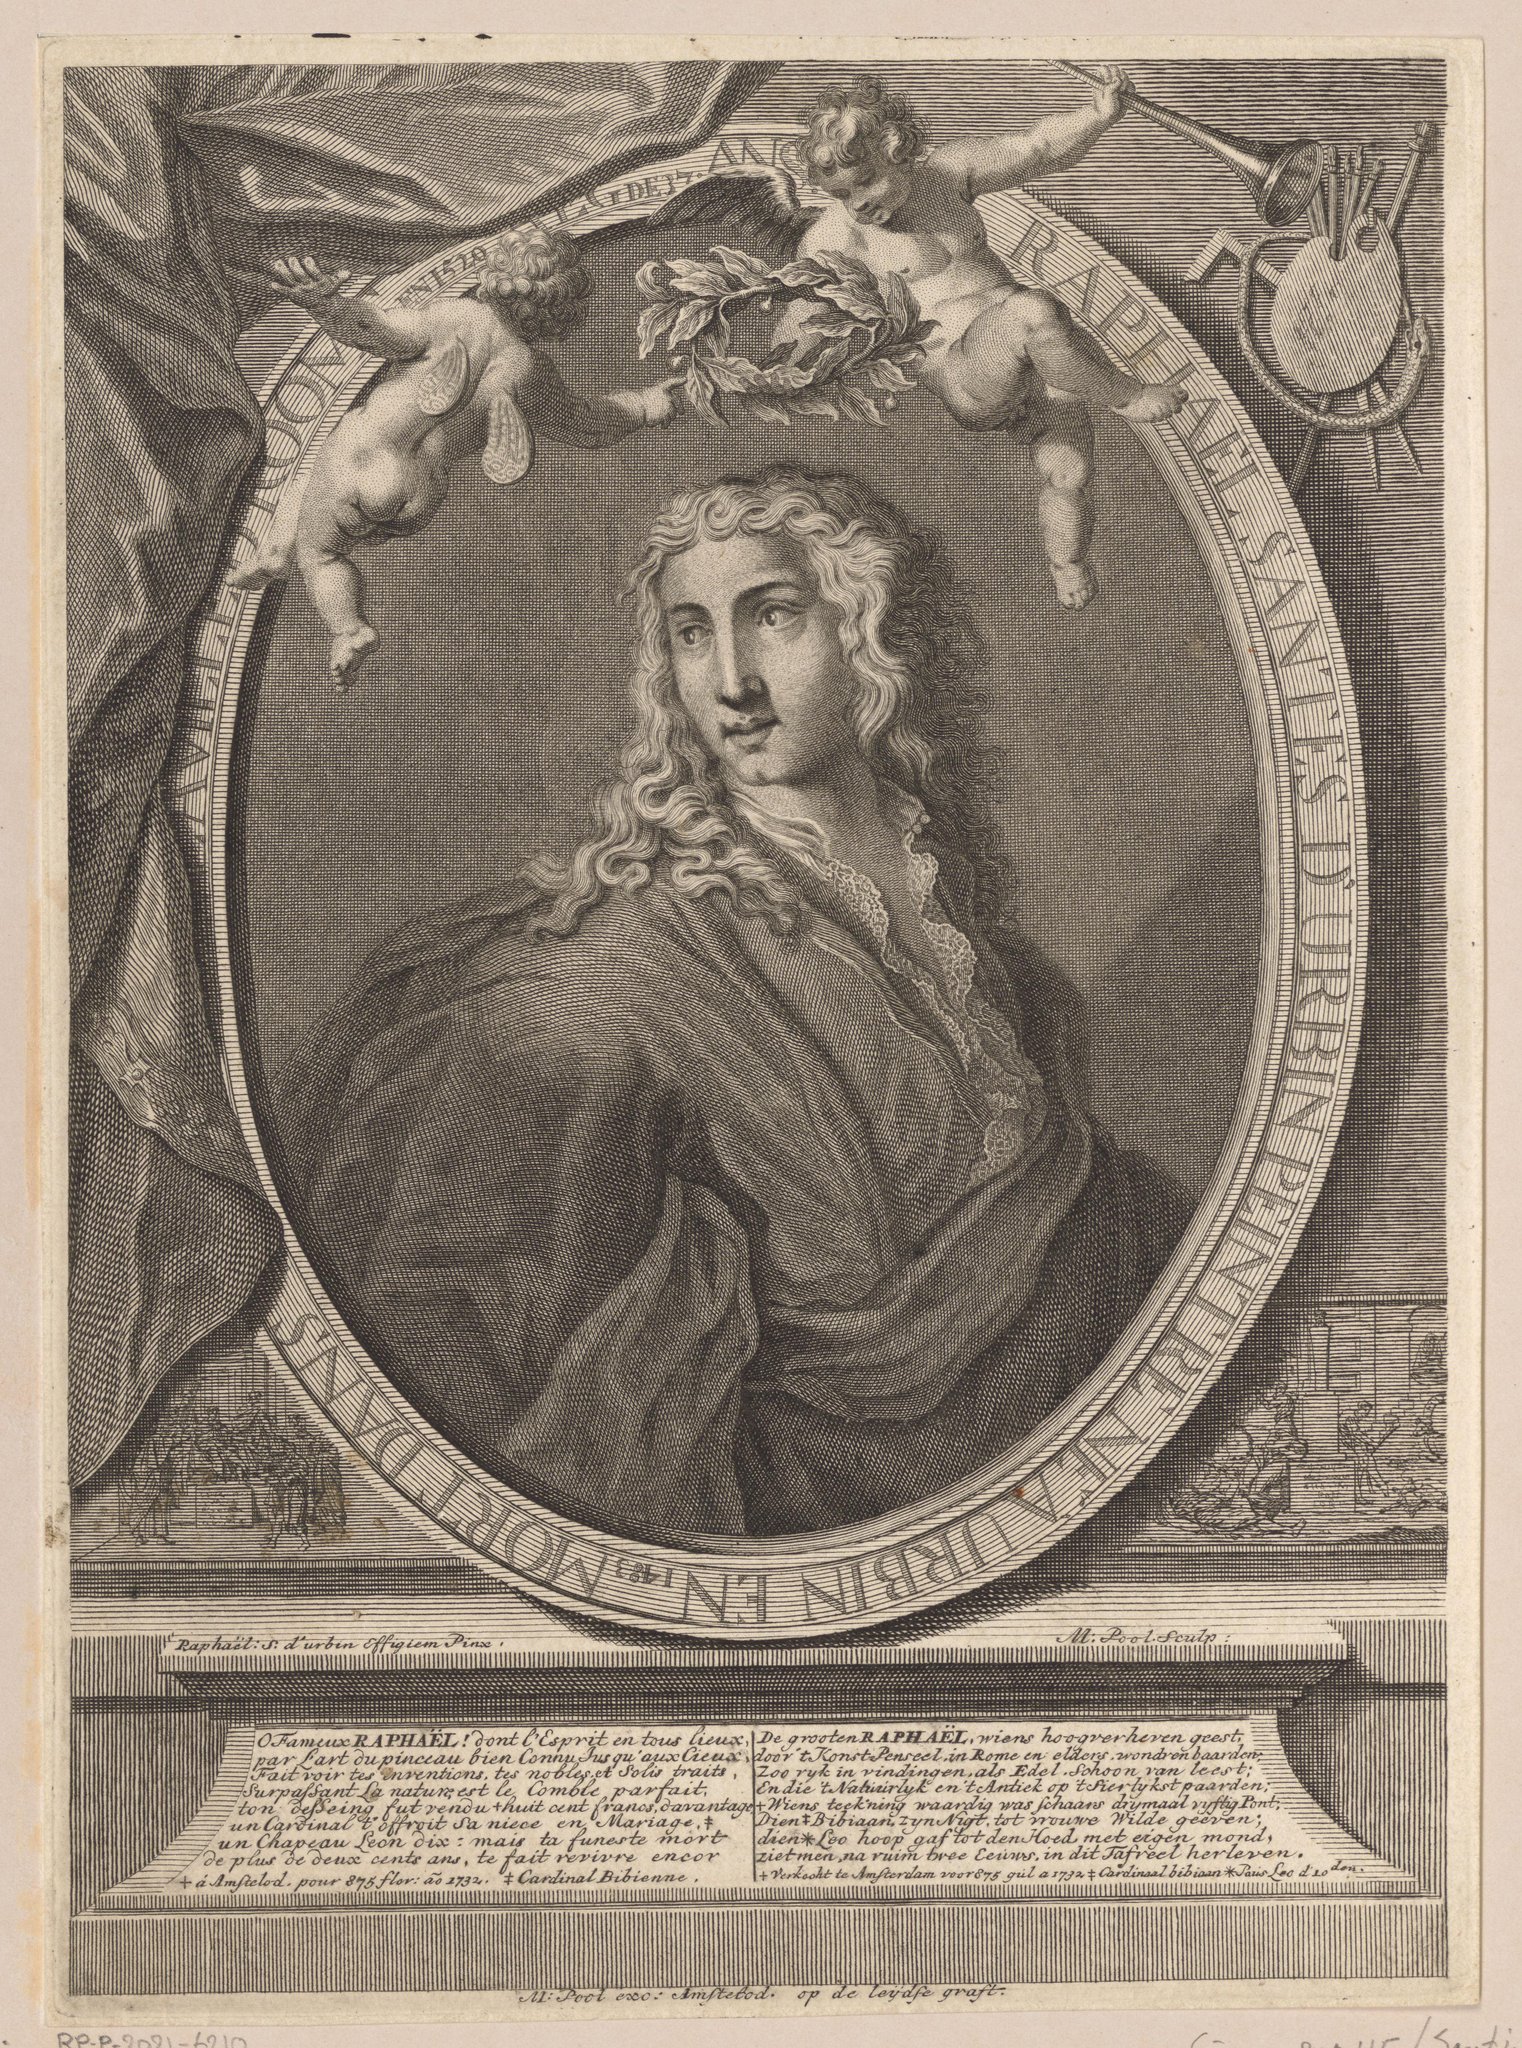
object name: print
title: Portret van Rafaël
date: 1732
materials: paper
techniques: engraving, etching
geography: amsterdam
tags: rome, painter, rafaël, historical persons, crowning with laurel, cupids: 'amores', 'amoretti', 'putti'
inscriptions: date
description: Rafaël wordt gekroond met een lauwerkrans door twee putti. Onder het portret een achtregelig vers.